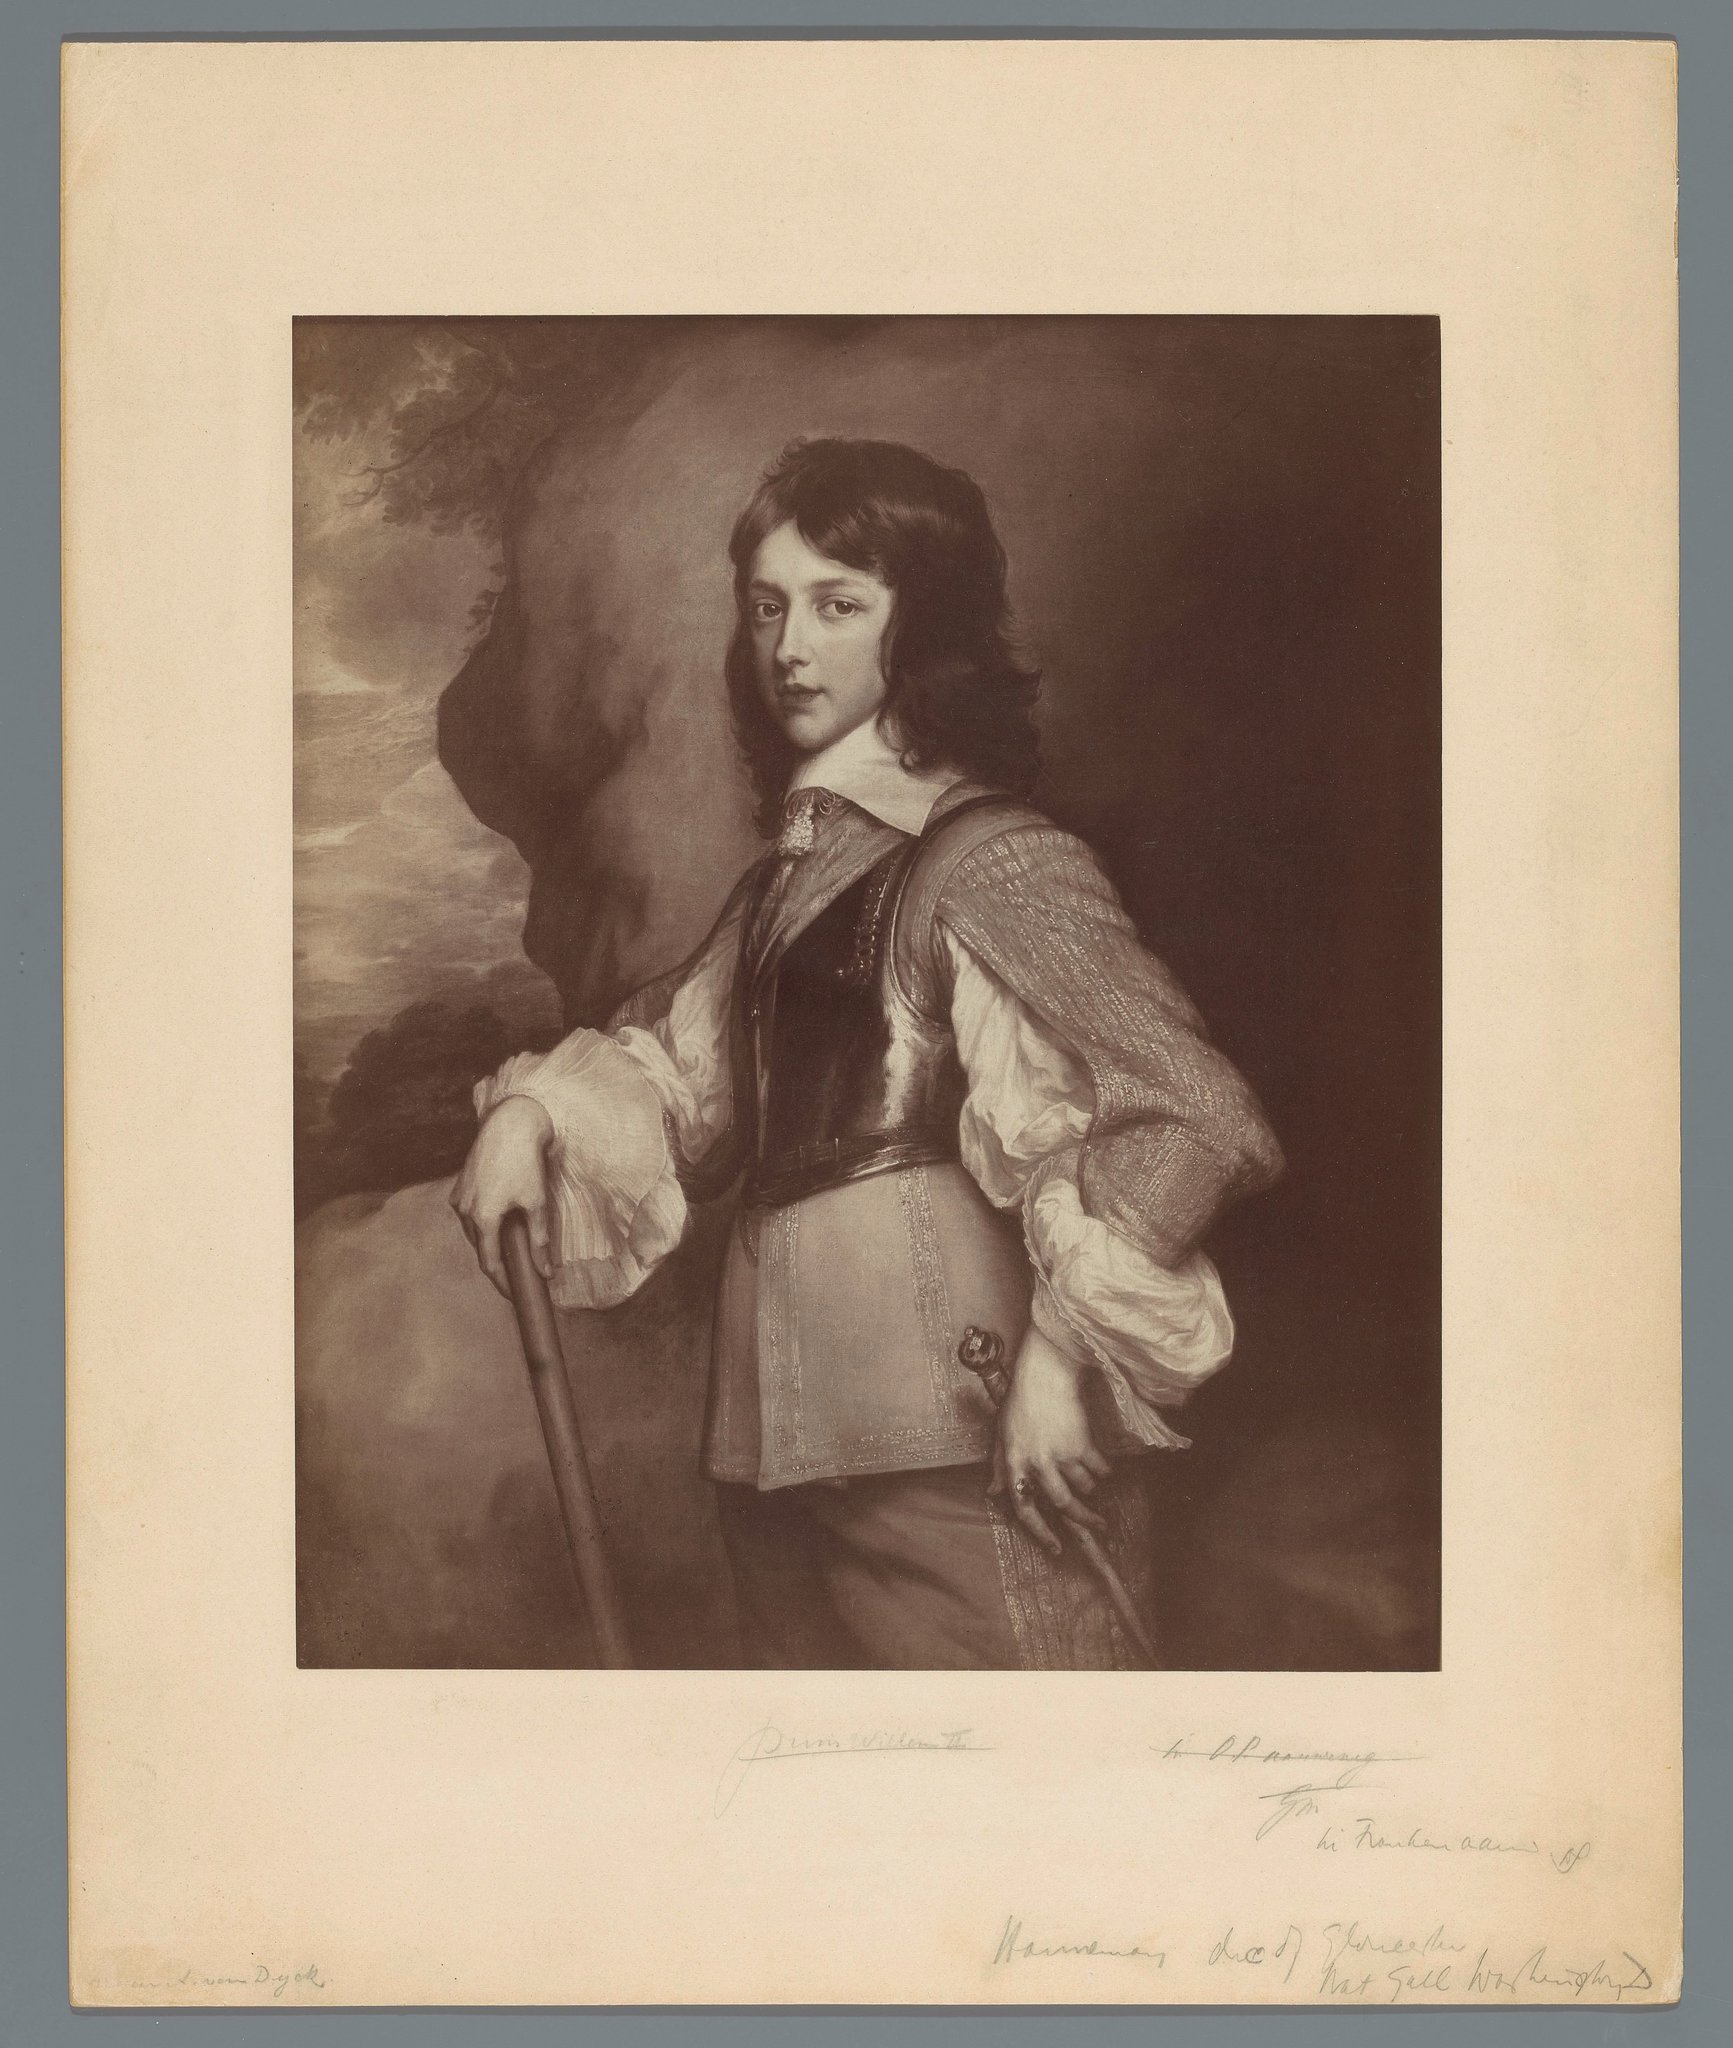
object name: reproduction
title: Prins Willem II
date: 1860-1890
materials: cardboard, paper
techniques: albumen print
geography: sint-petersburg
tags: the hague, william ii of the netherlands, prince, historical persons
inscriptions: inscription: ‘Prins Willem II naar het olieverfportret van Ant. van Dyck/ in het Museum "Hermitage" te St Petersburg.’, inscription: ‘[...] A. van Dyck/ prins Willem II/ [...]’